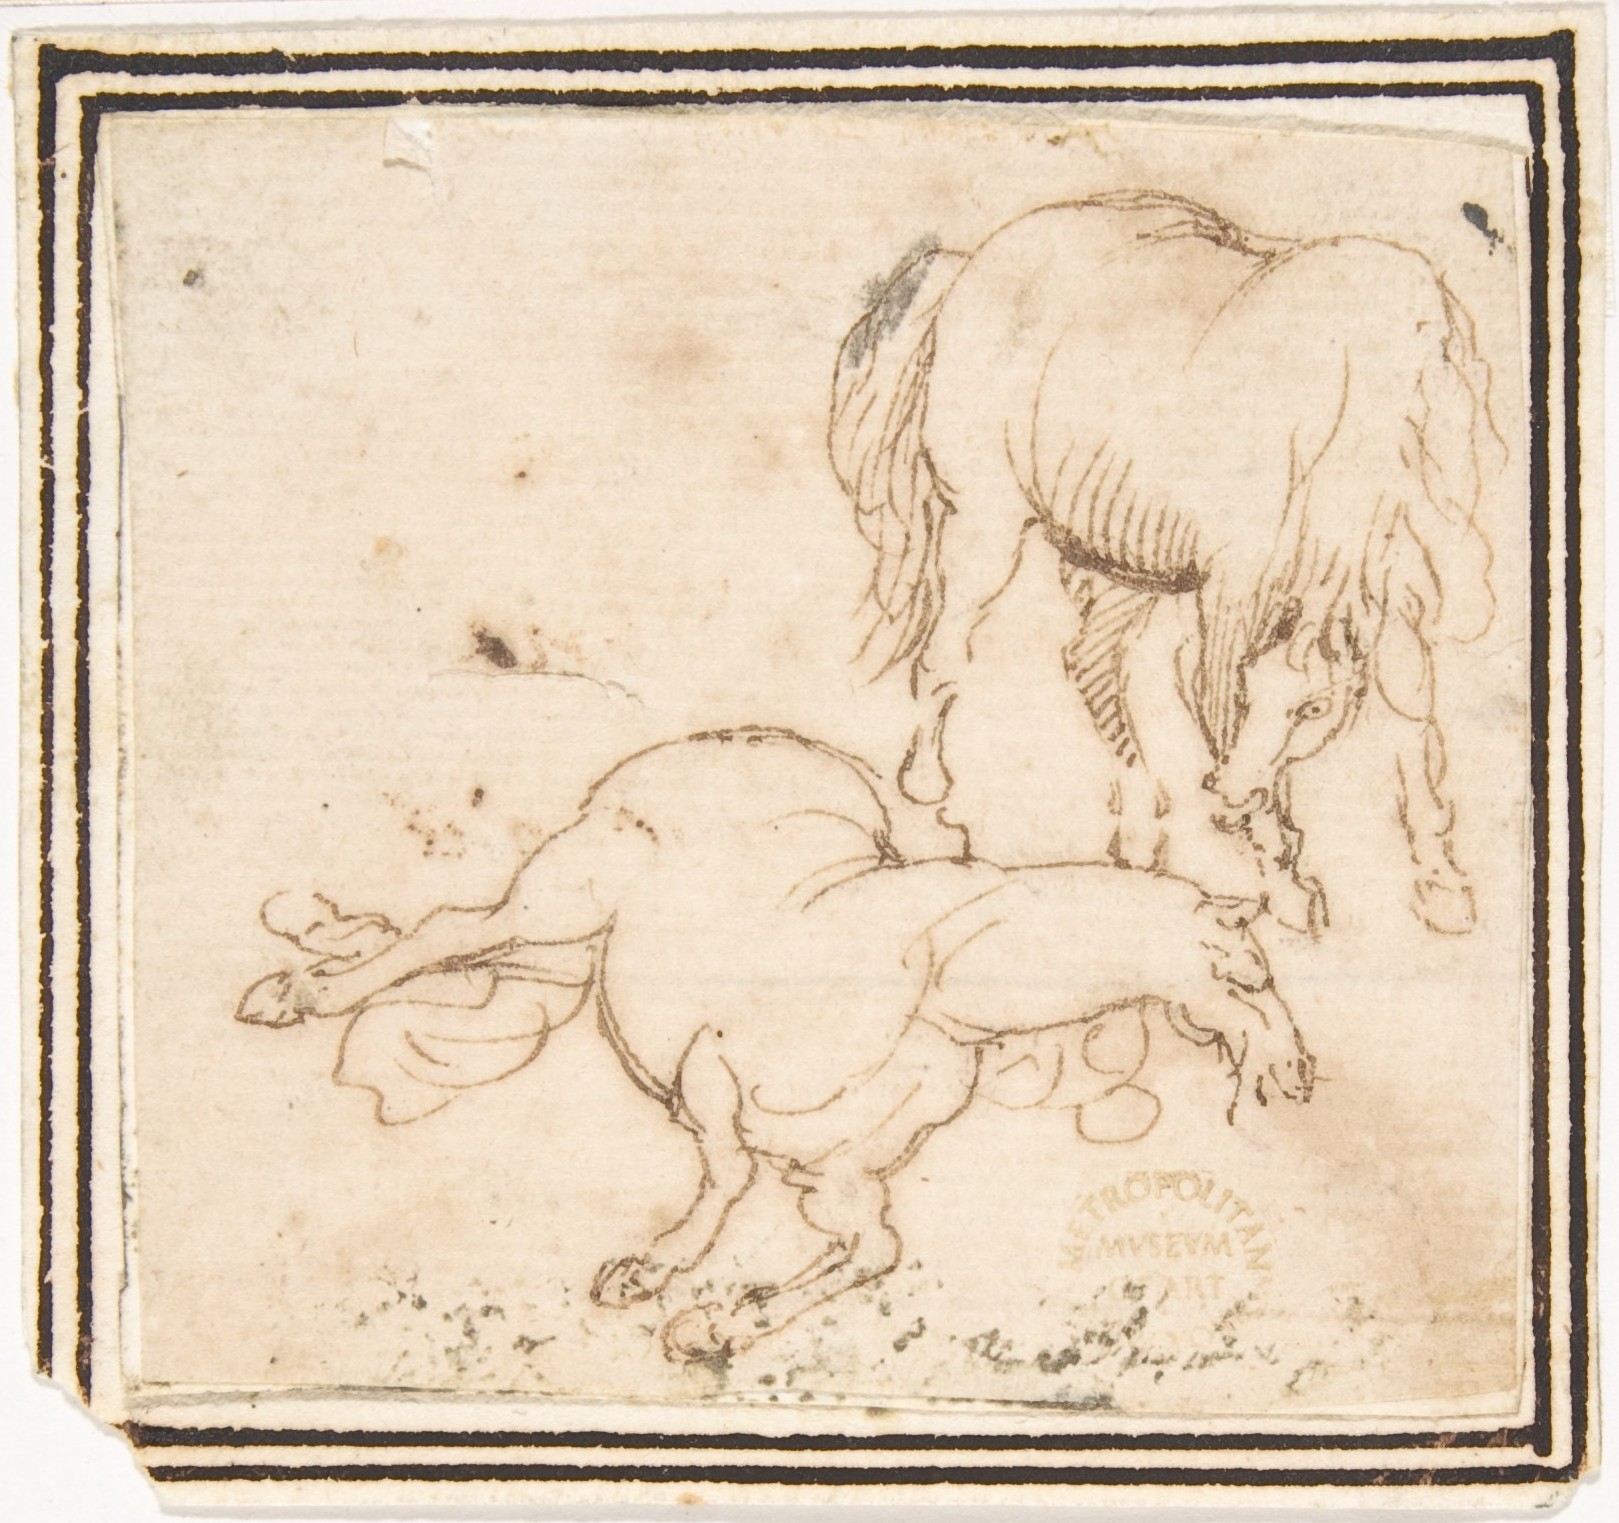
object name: drawing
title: Horses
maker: francesco allegrini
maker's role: artist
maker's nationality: italian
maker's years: 1615-1679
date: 1624-1663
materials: ink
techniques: pen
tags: horses